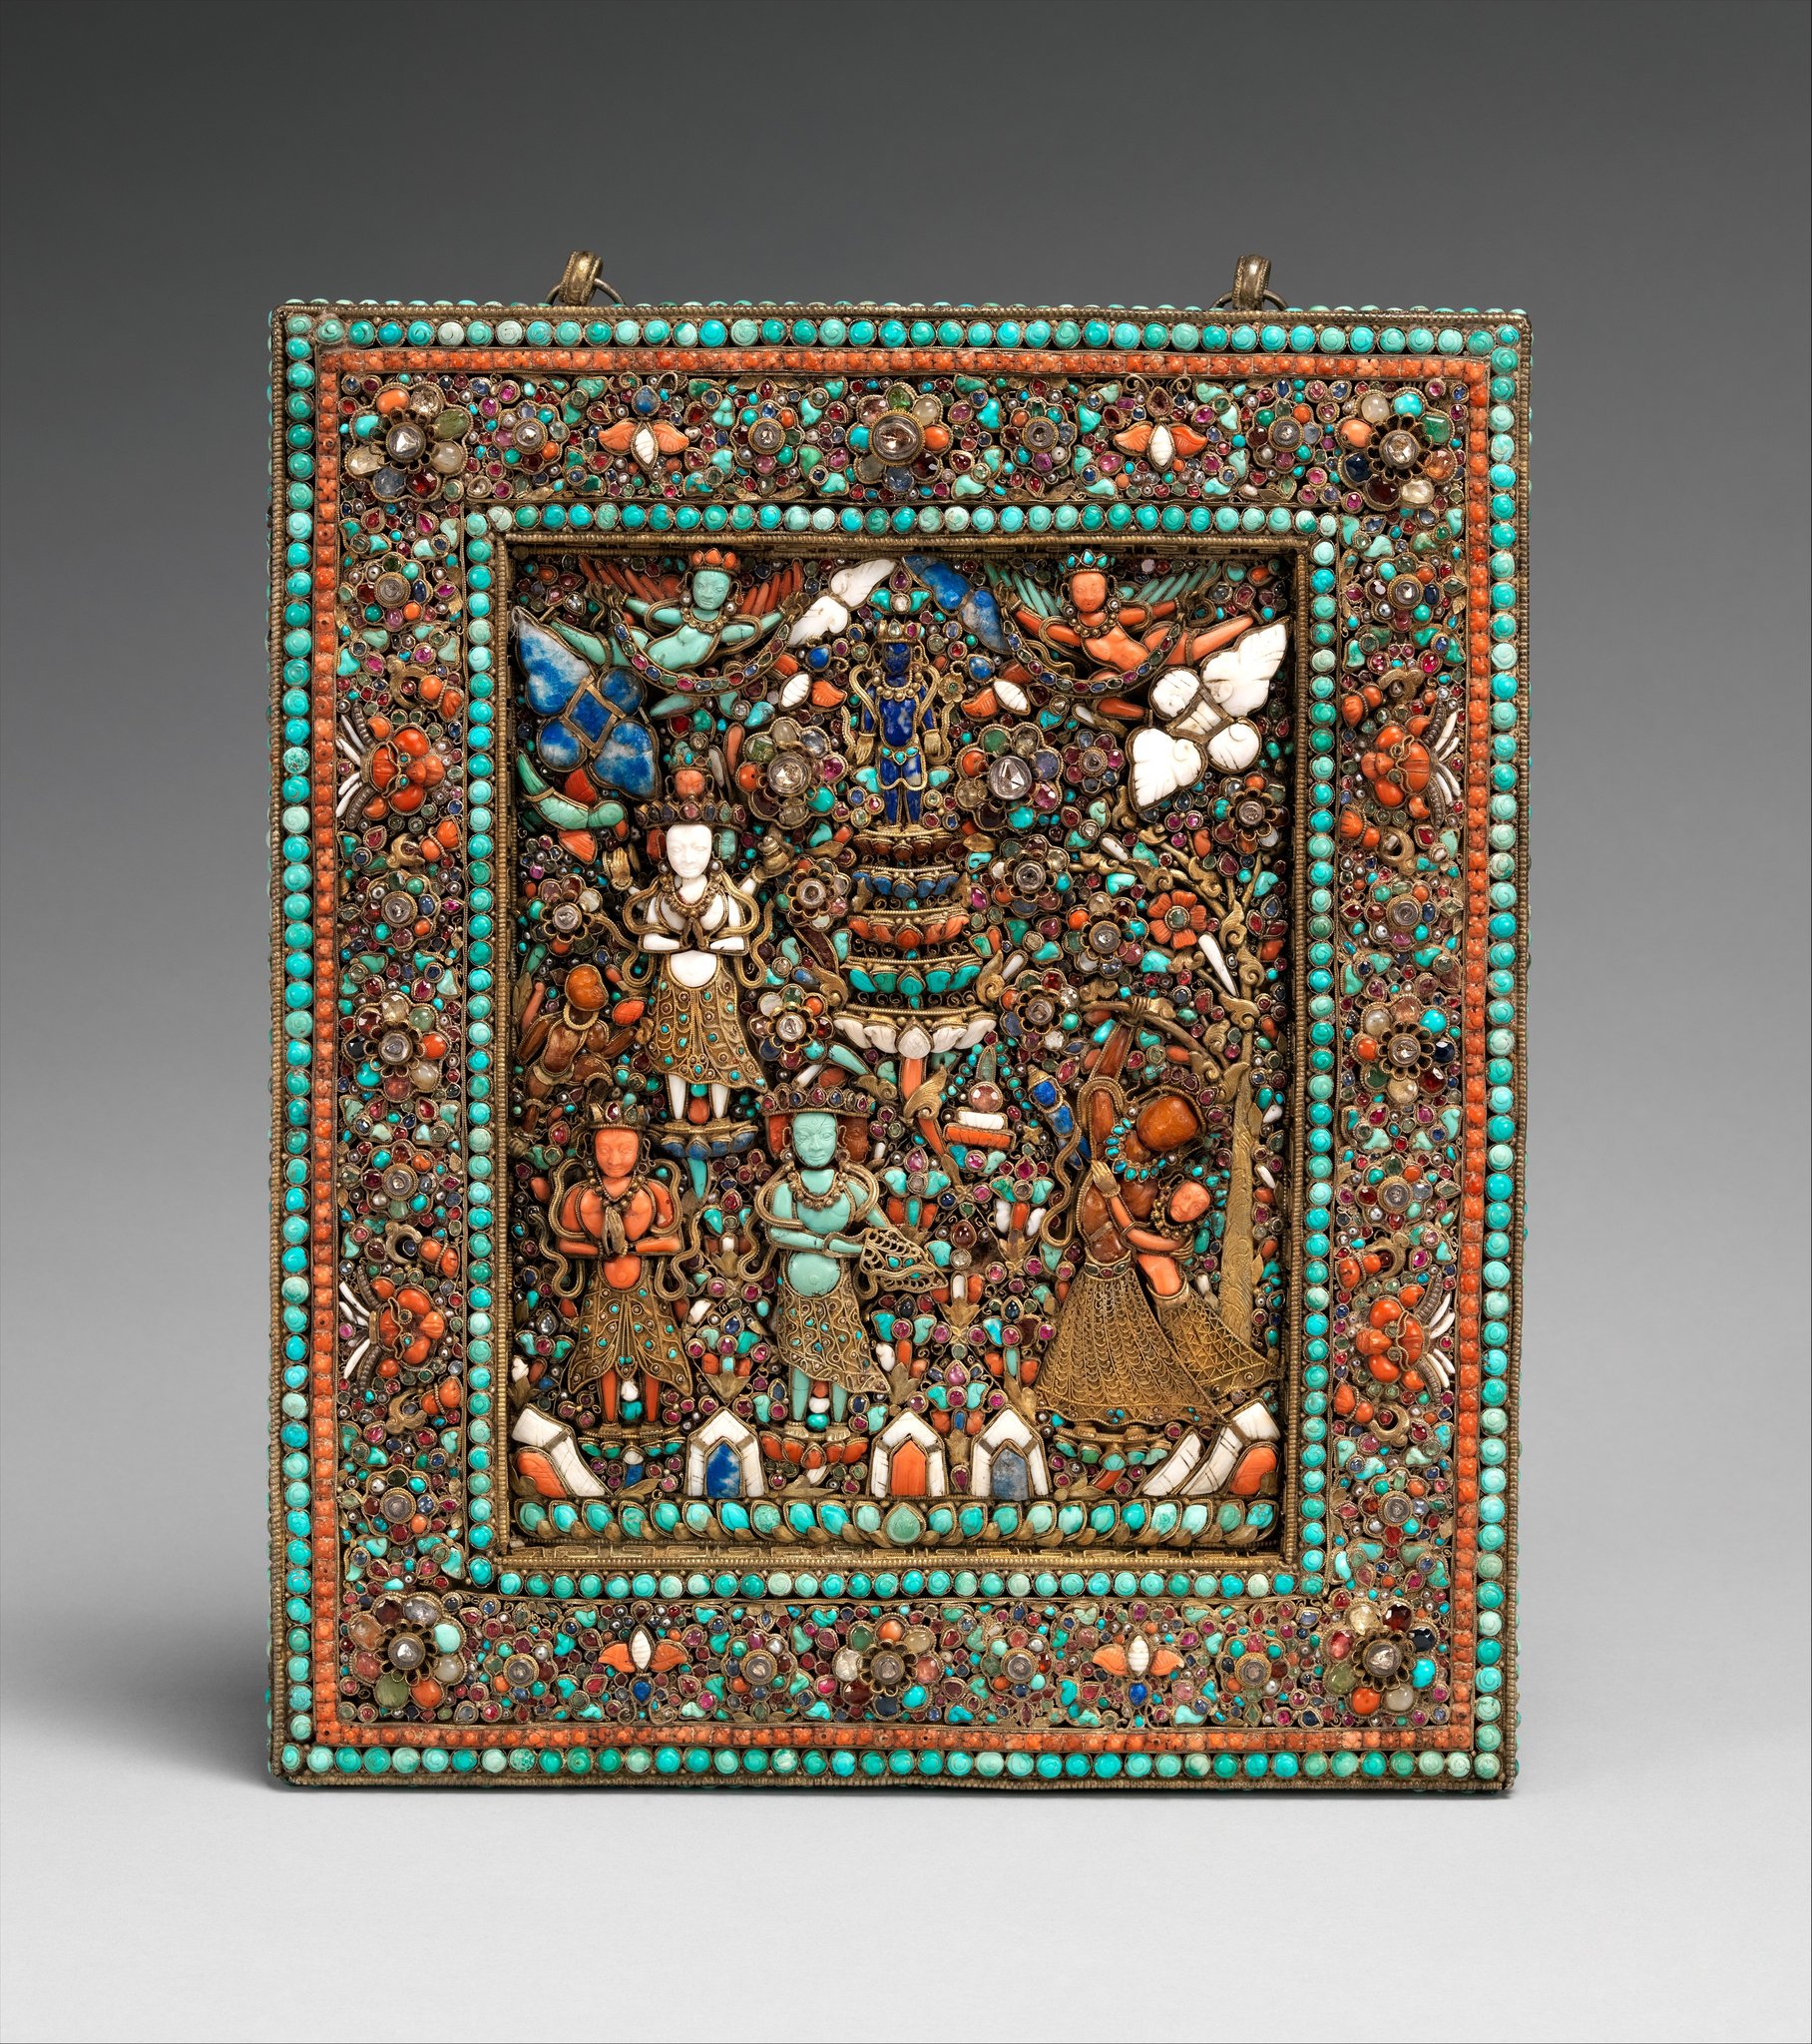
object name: votive plaque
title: The Birth of the Buddha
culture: nepali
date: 1701-1900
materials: amber, coral, diamond, gemstone, garnet, silver gilt, lapis lazuli, pearl, quartz, stone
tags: buddhism,buddha,brahma,birth